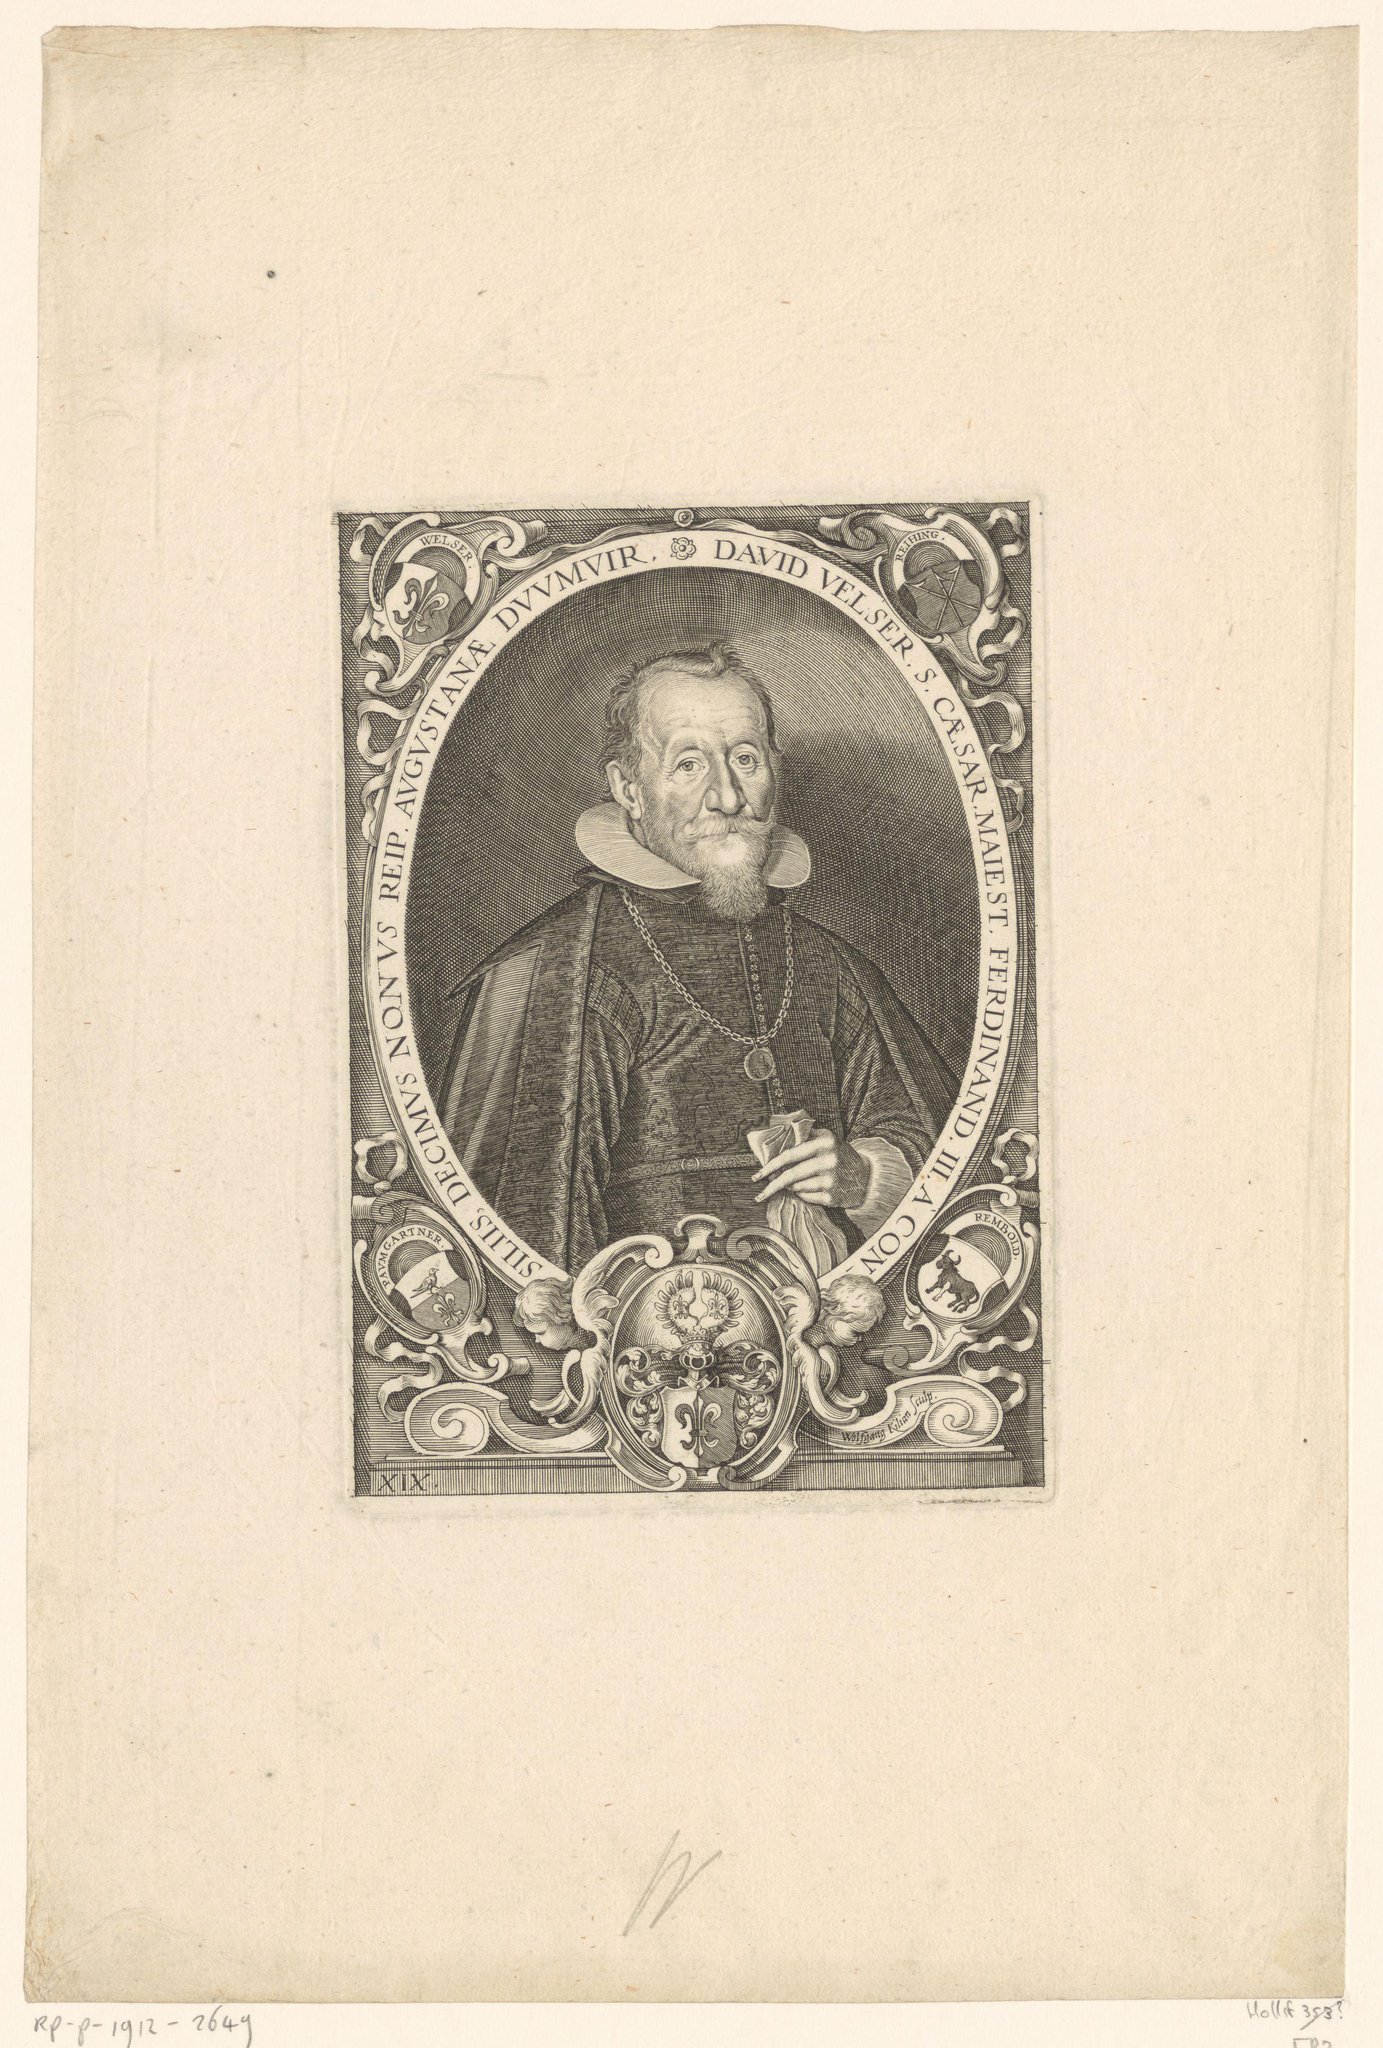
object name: print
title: Portret van David Welser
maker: wolfgang kilian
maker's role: print maker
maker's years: 1581-1662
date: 1614-1625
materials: paper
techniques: engraving, etching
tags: mayor, burgomaster, historical persons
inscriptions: collector's mark: Lugt 2228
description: Deze prent is mogelijk gebruikt in een Duitse versie van: Kilian, Wolfgang. Brevis et Succincta Descriptio omnium Saxoniae Electorum (...). S.l.s.n., 1625.